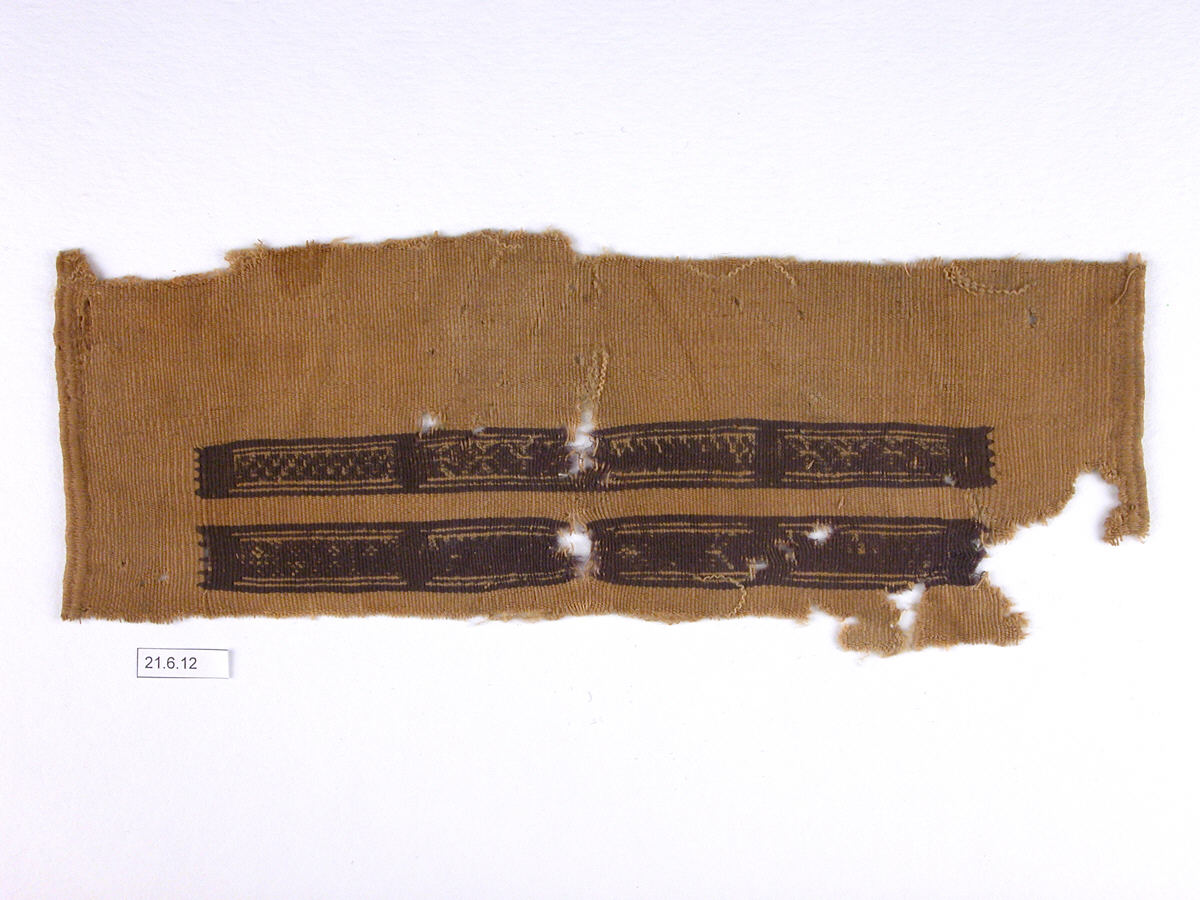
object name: fragment of a sleeve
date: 301-400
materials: wool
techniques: tapestry, weave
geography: egypt